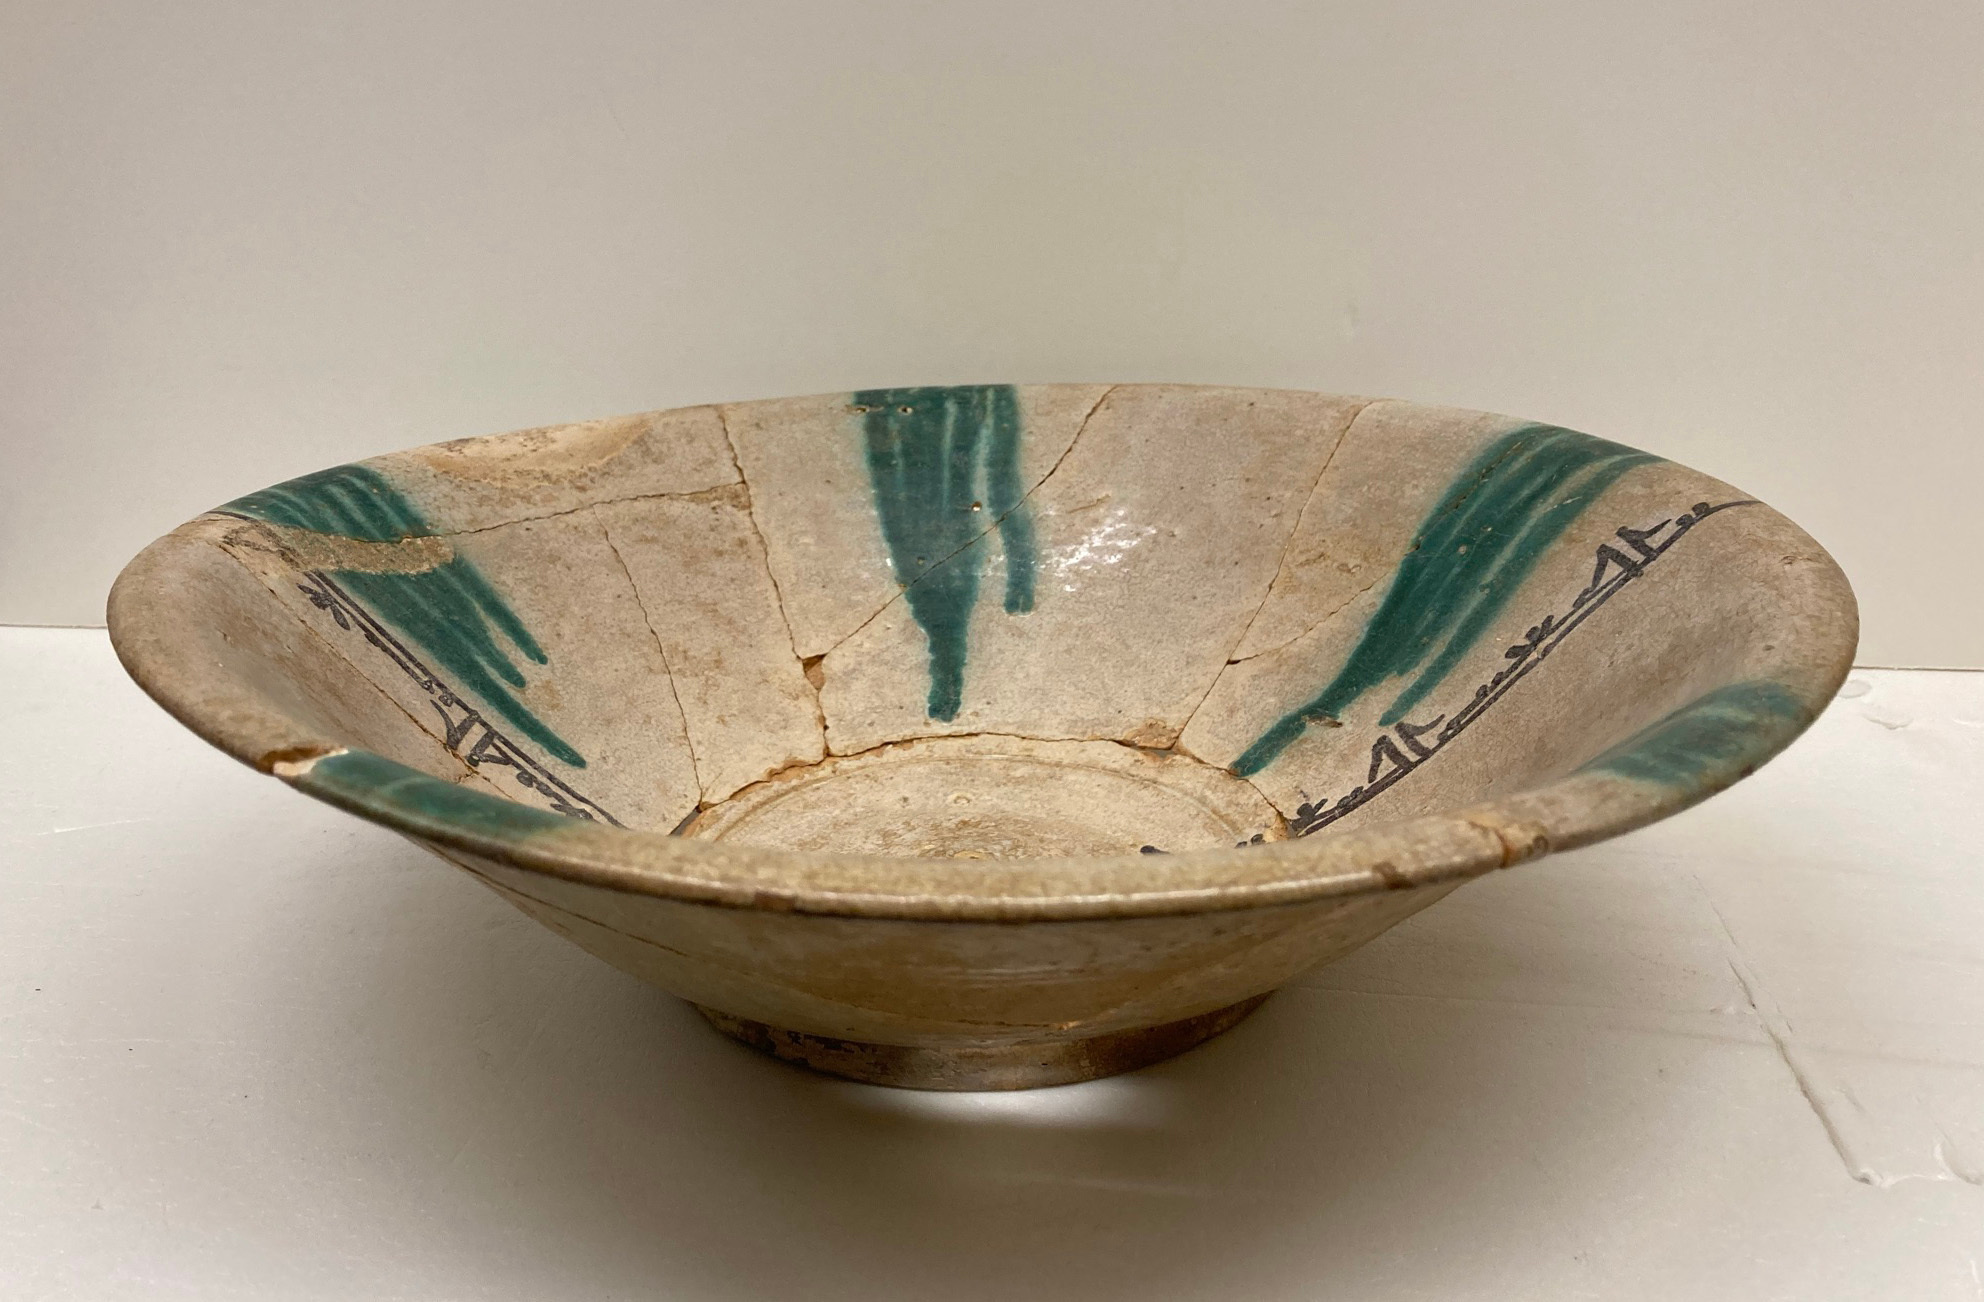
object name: bowl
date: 701-900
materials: earthenware, glaze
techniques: painting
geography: iran